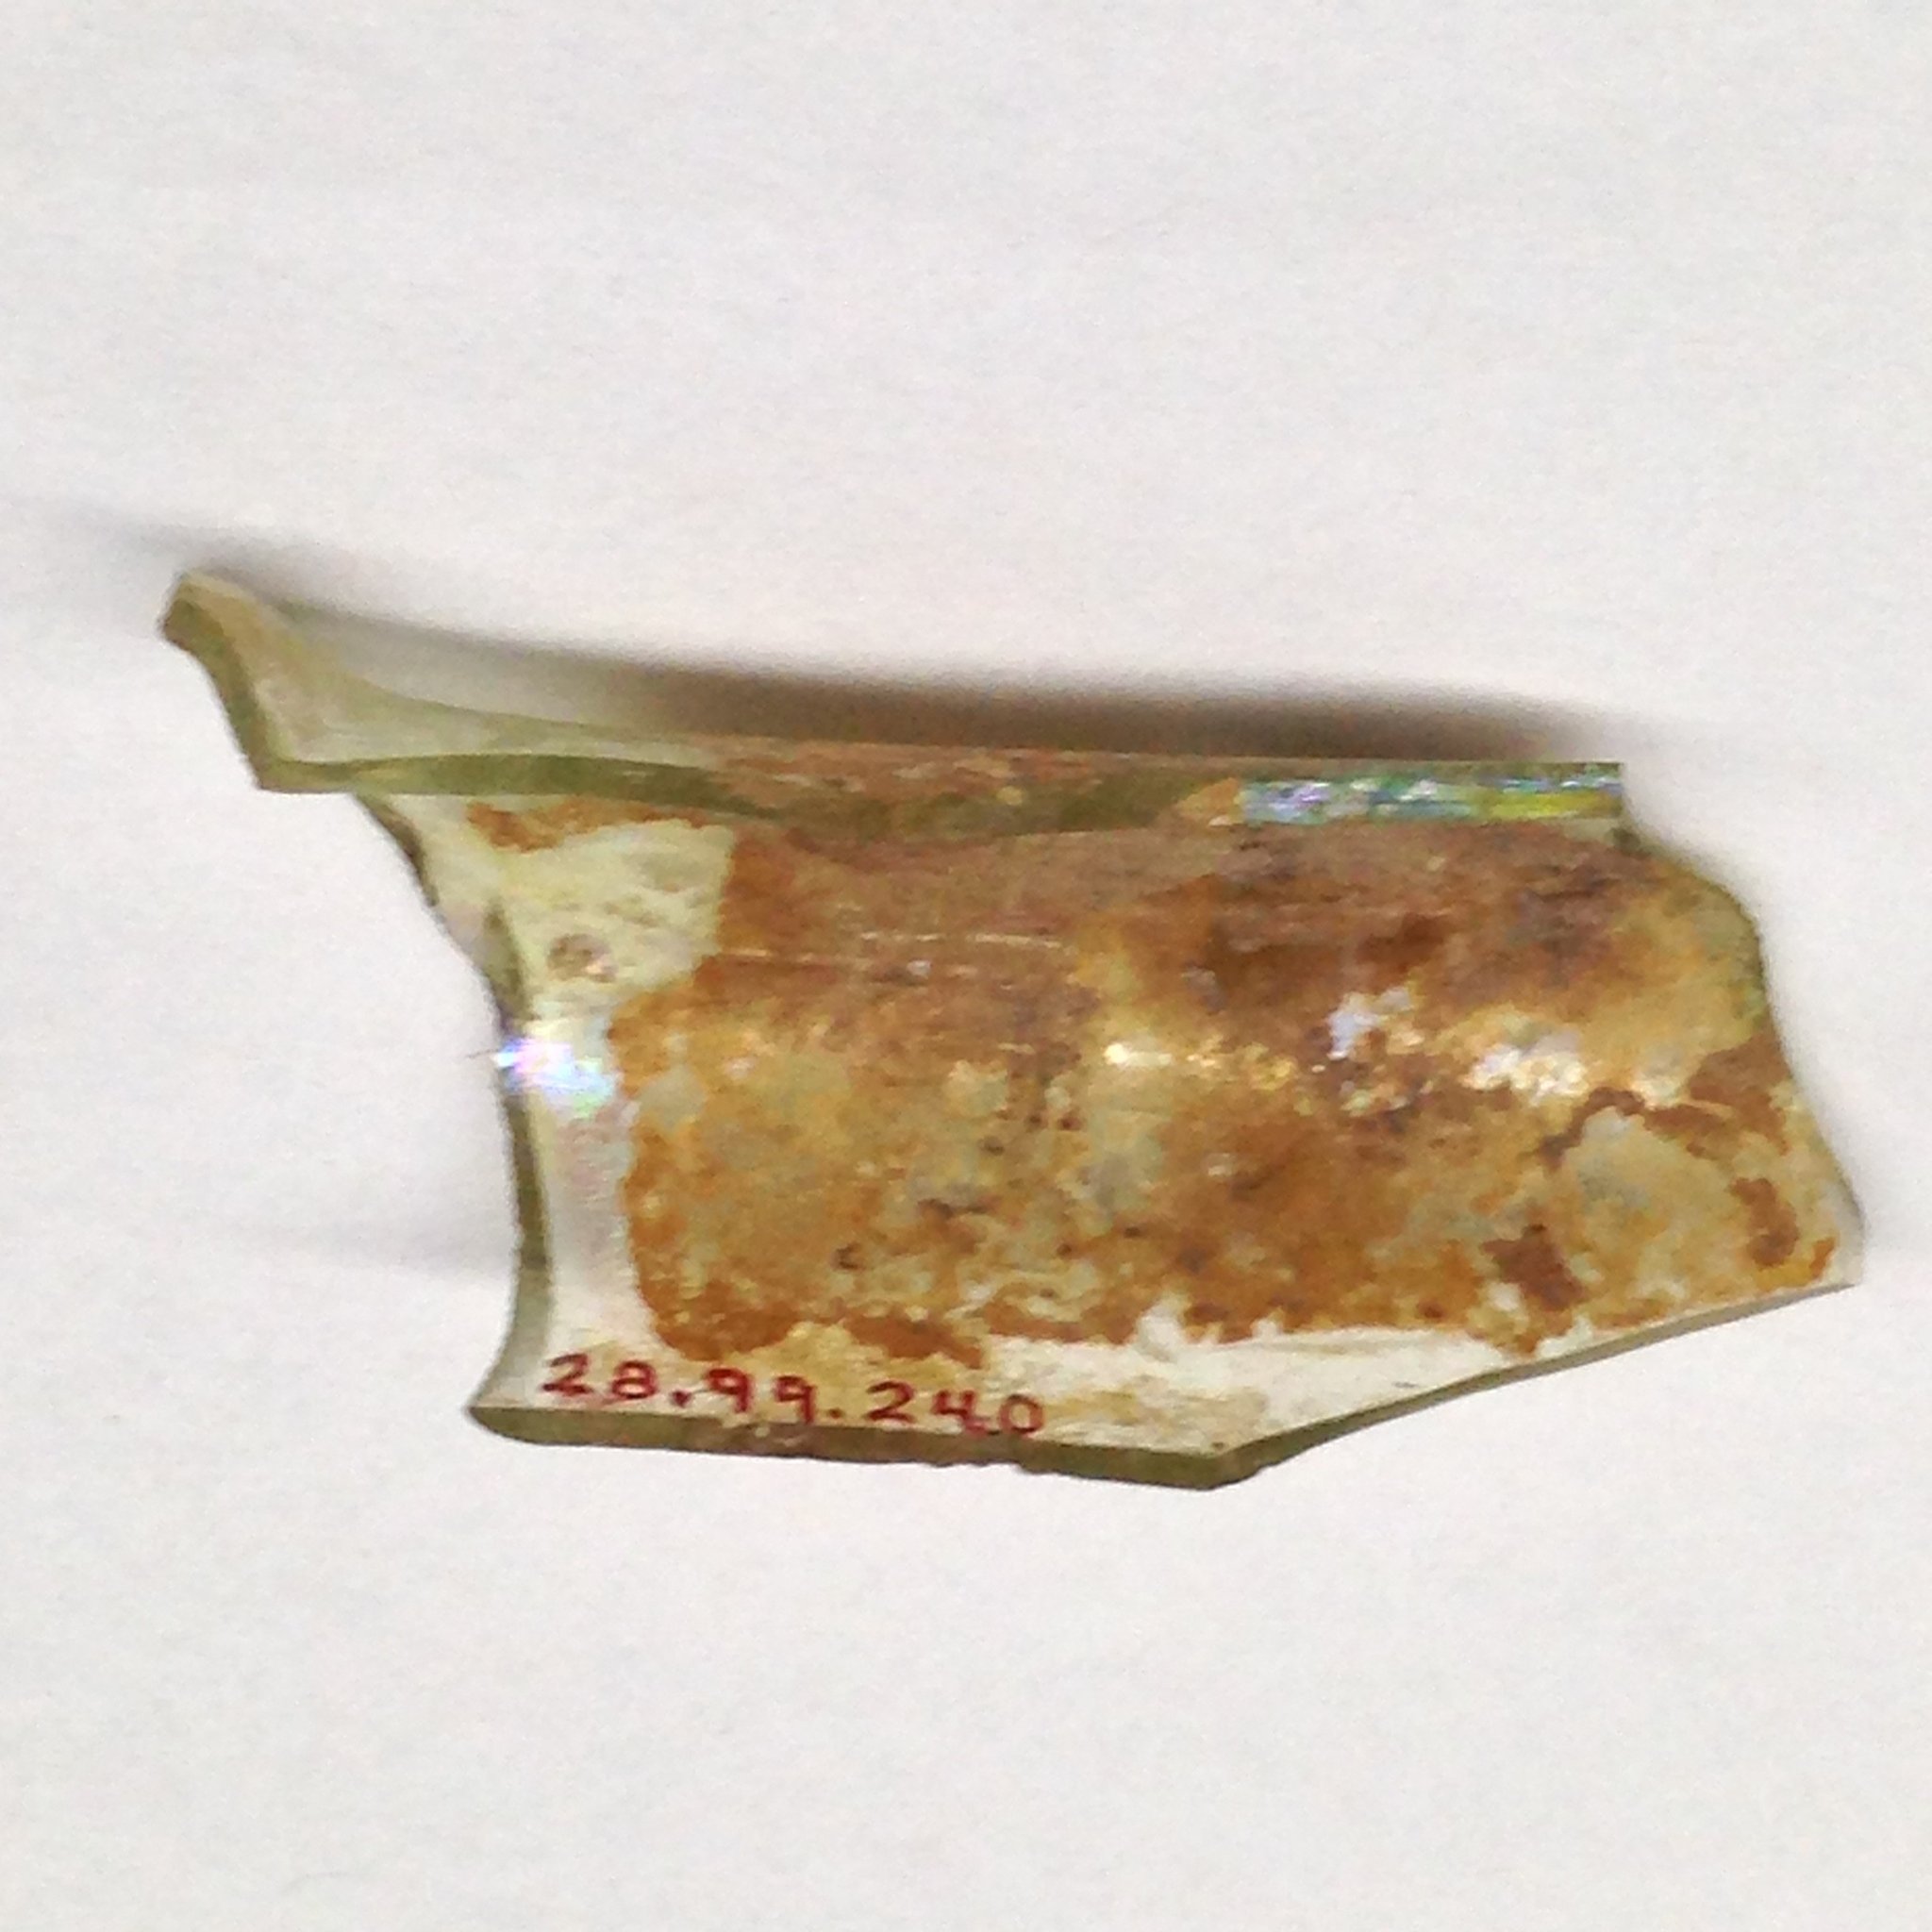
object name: fragment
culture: european or middle eastern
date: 1150-1250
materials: ceramic, glass